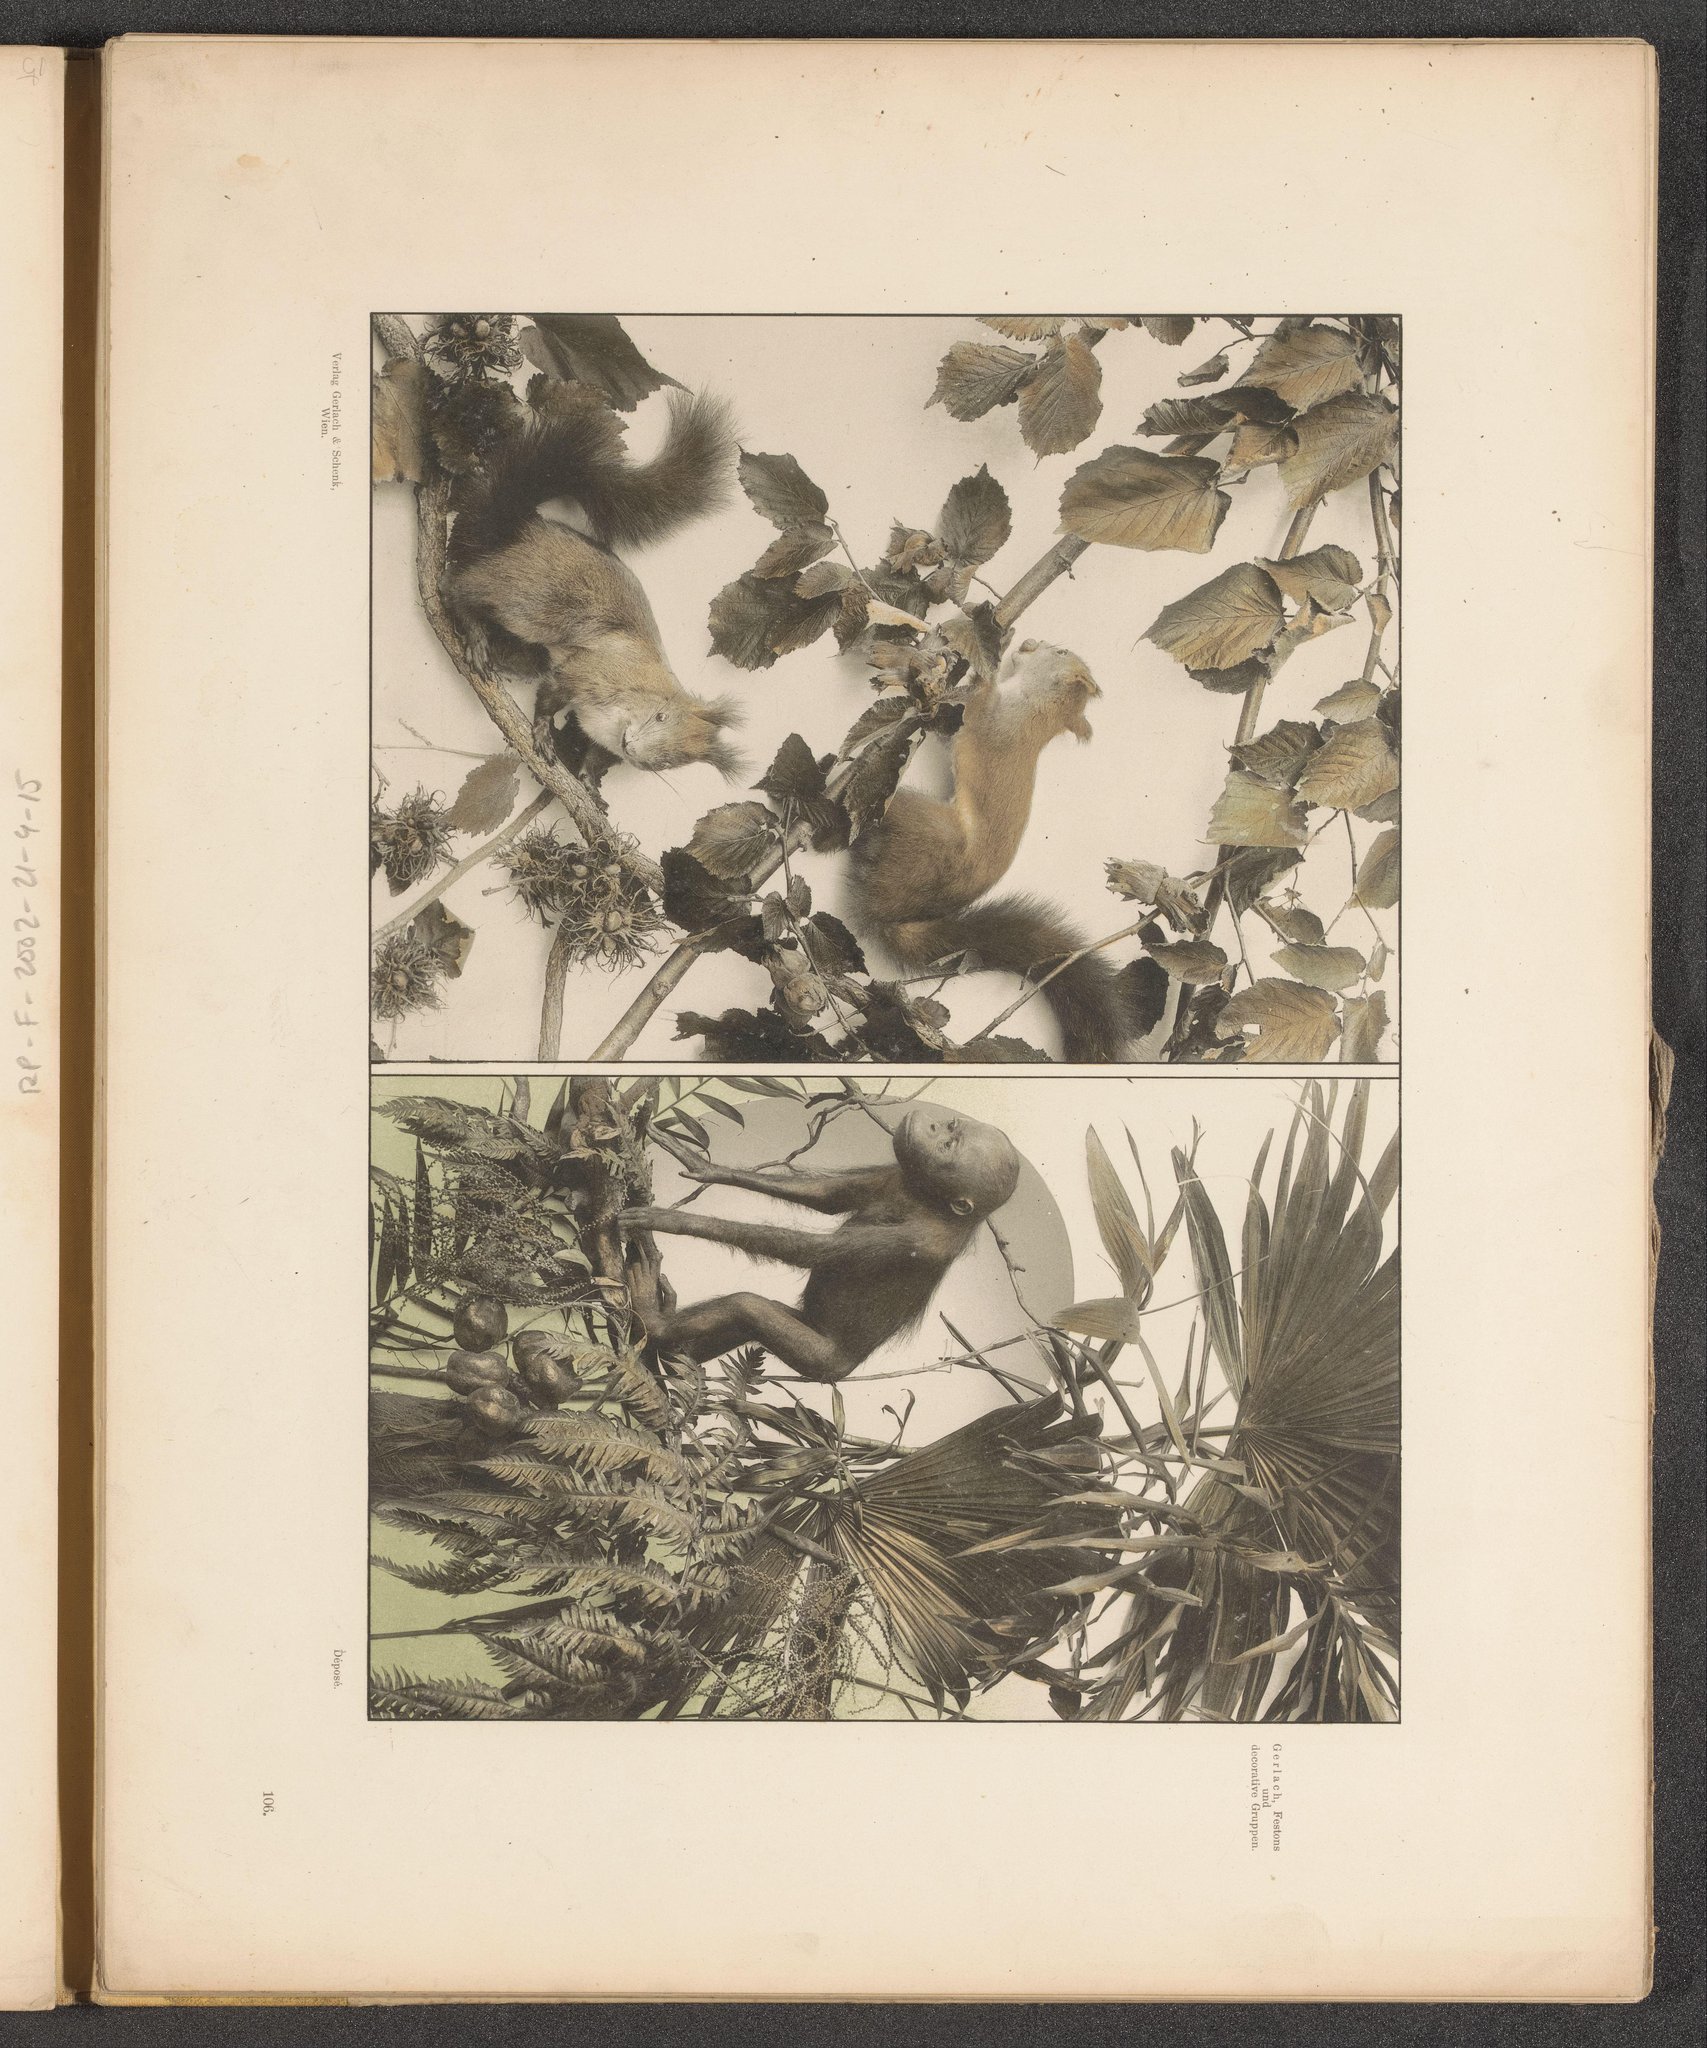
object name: page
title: Decoratieve groepen met hazelaartakken, eekhoorns, palmbladeren en een orang-oetan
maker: Anonymous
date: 1887-1897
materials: paper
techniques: photograph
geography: austria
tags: trees: palm-tree (+ leaf), monkeys, apes, rodents: squirrel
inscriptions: number: ‘106.’